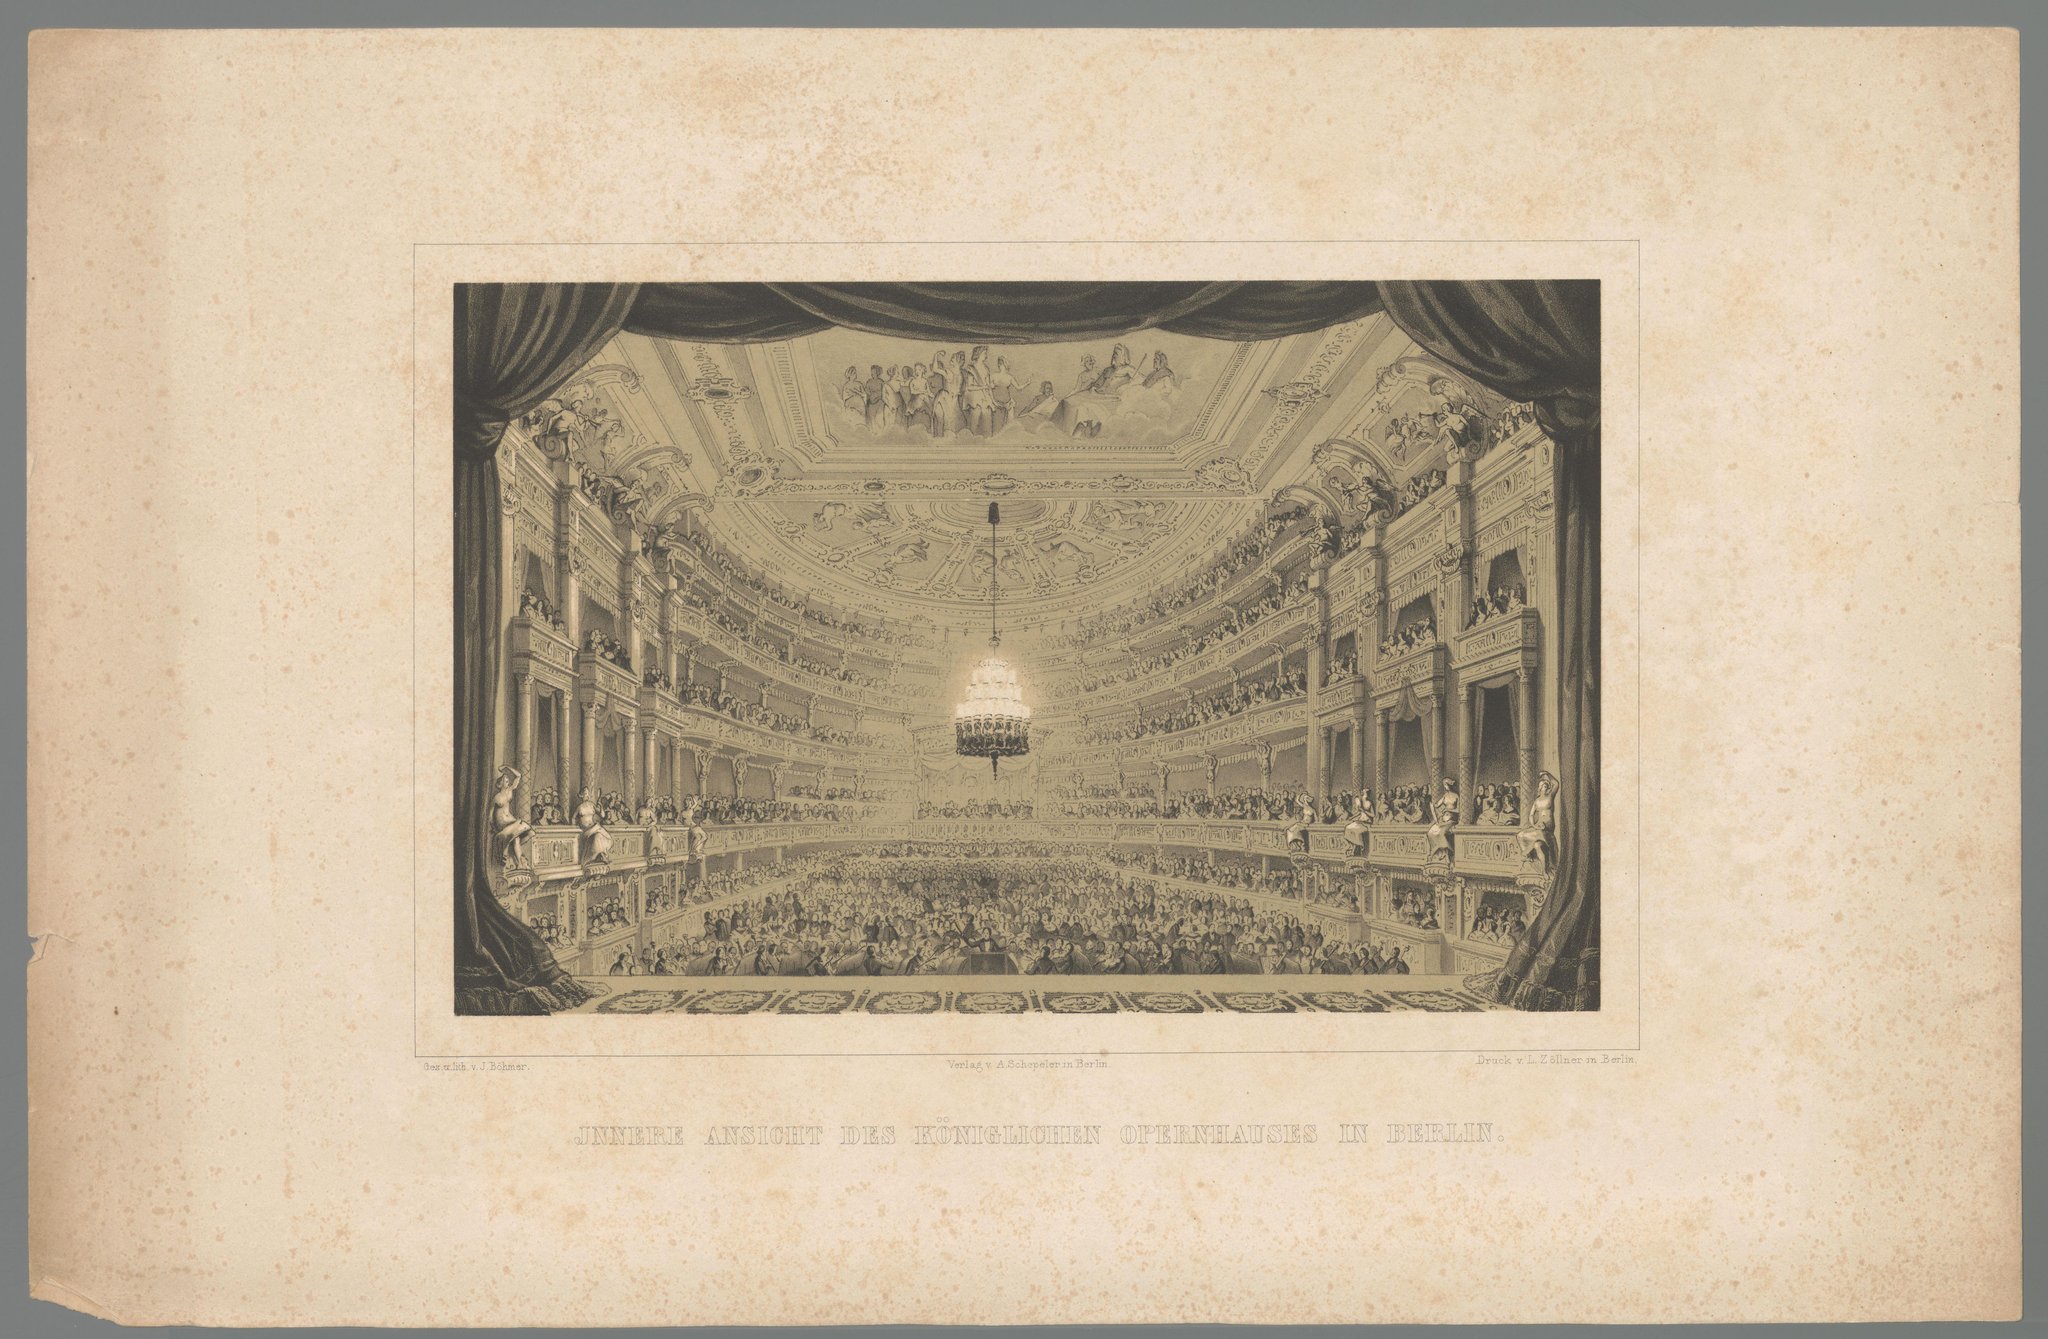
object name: print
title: Interieur van de Hofoper te Berlijn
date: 1844-1899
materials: paper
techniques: tone lithography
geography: berlin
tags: large group of musicians, orchestra, chandelier, candelabrum, opera house, berlin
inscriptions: collector's mark: Lugt 2228